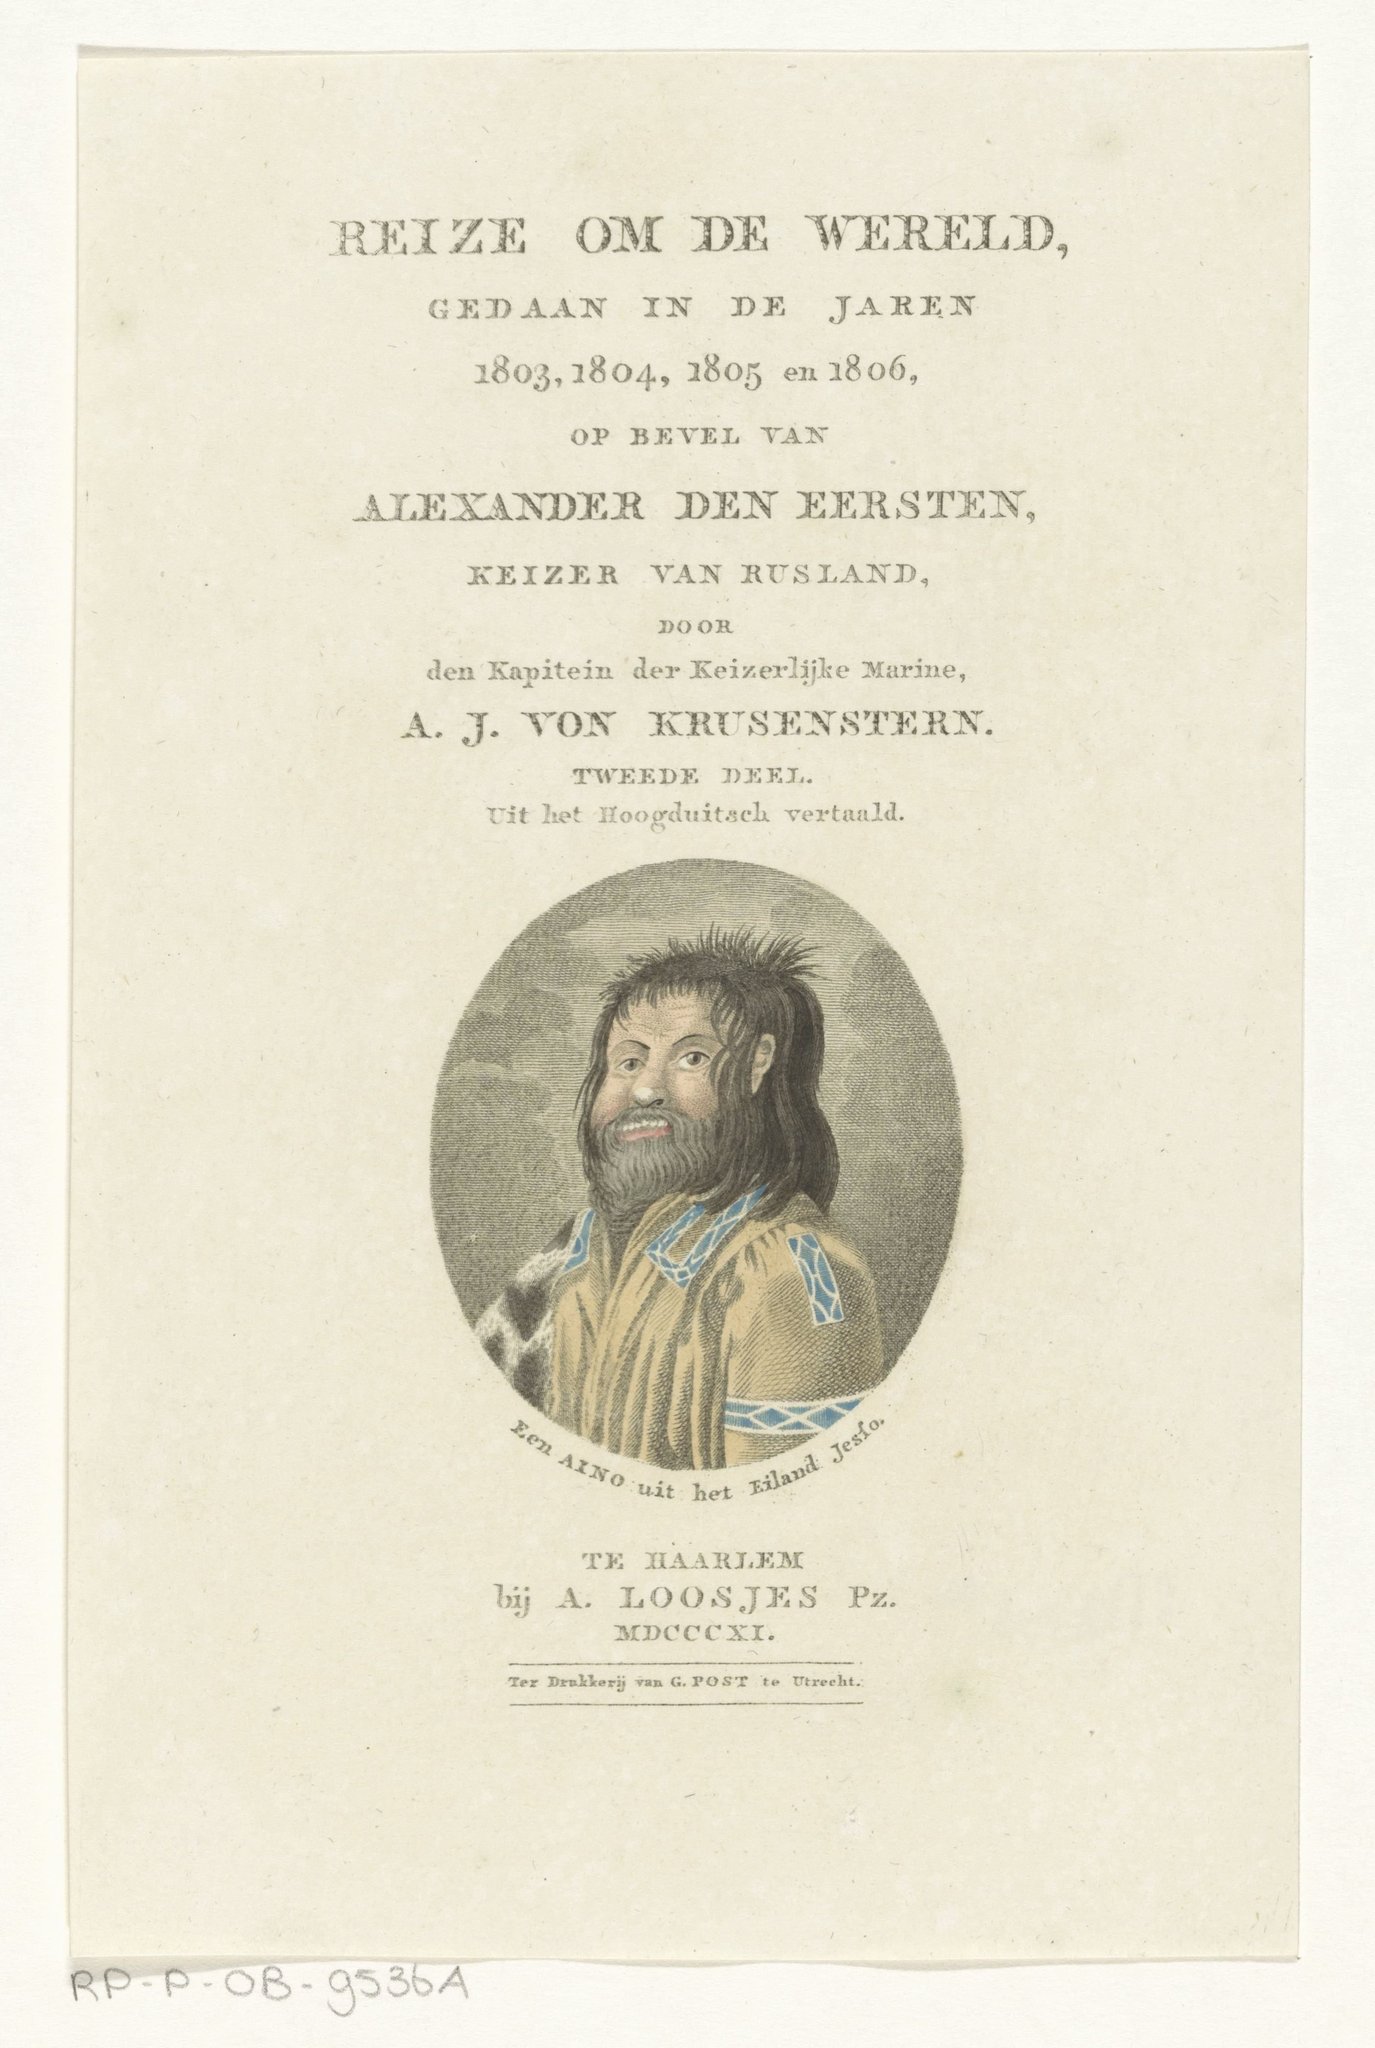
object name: print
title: Een Aino uit het Eiland Jesfo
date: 1811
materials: paper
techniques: engraving, etching, hand coloring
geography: haarlem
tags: asiatic races and peoples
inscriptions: collector's mark: Lugt 2228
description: Titelpagina voor: Krusenstern, A.J. von. Reize om de wereld, gedaan in de jaren 1803, 1804, 1805 en 1806, op bevel van Alexander den Eersten, keizer van Rusland. Tweede deel. Haarlem: Loosjes, Adriaan Pietersz., 1811.